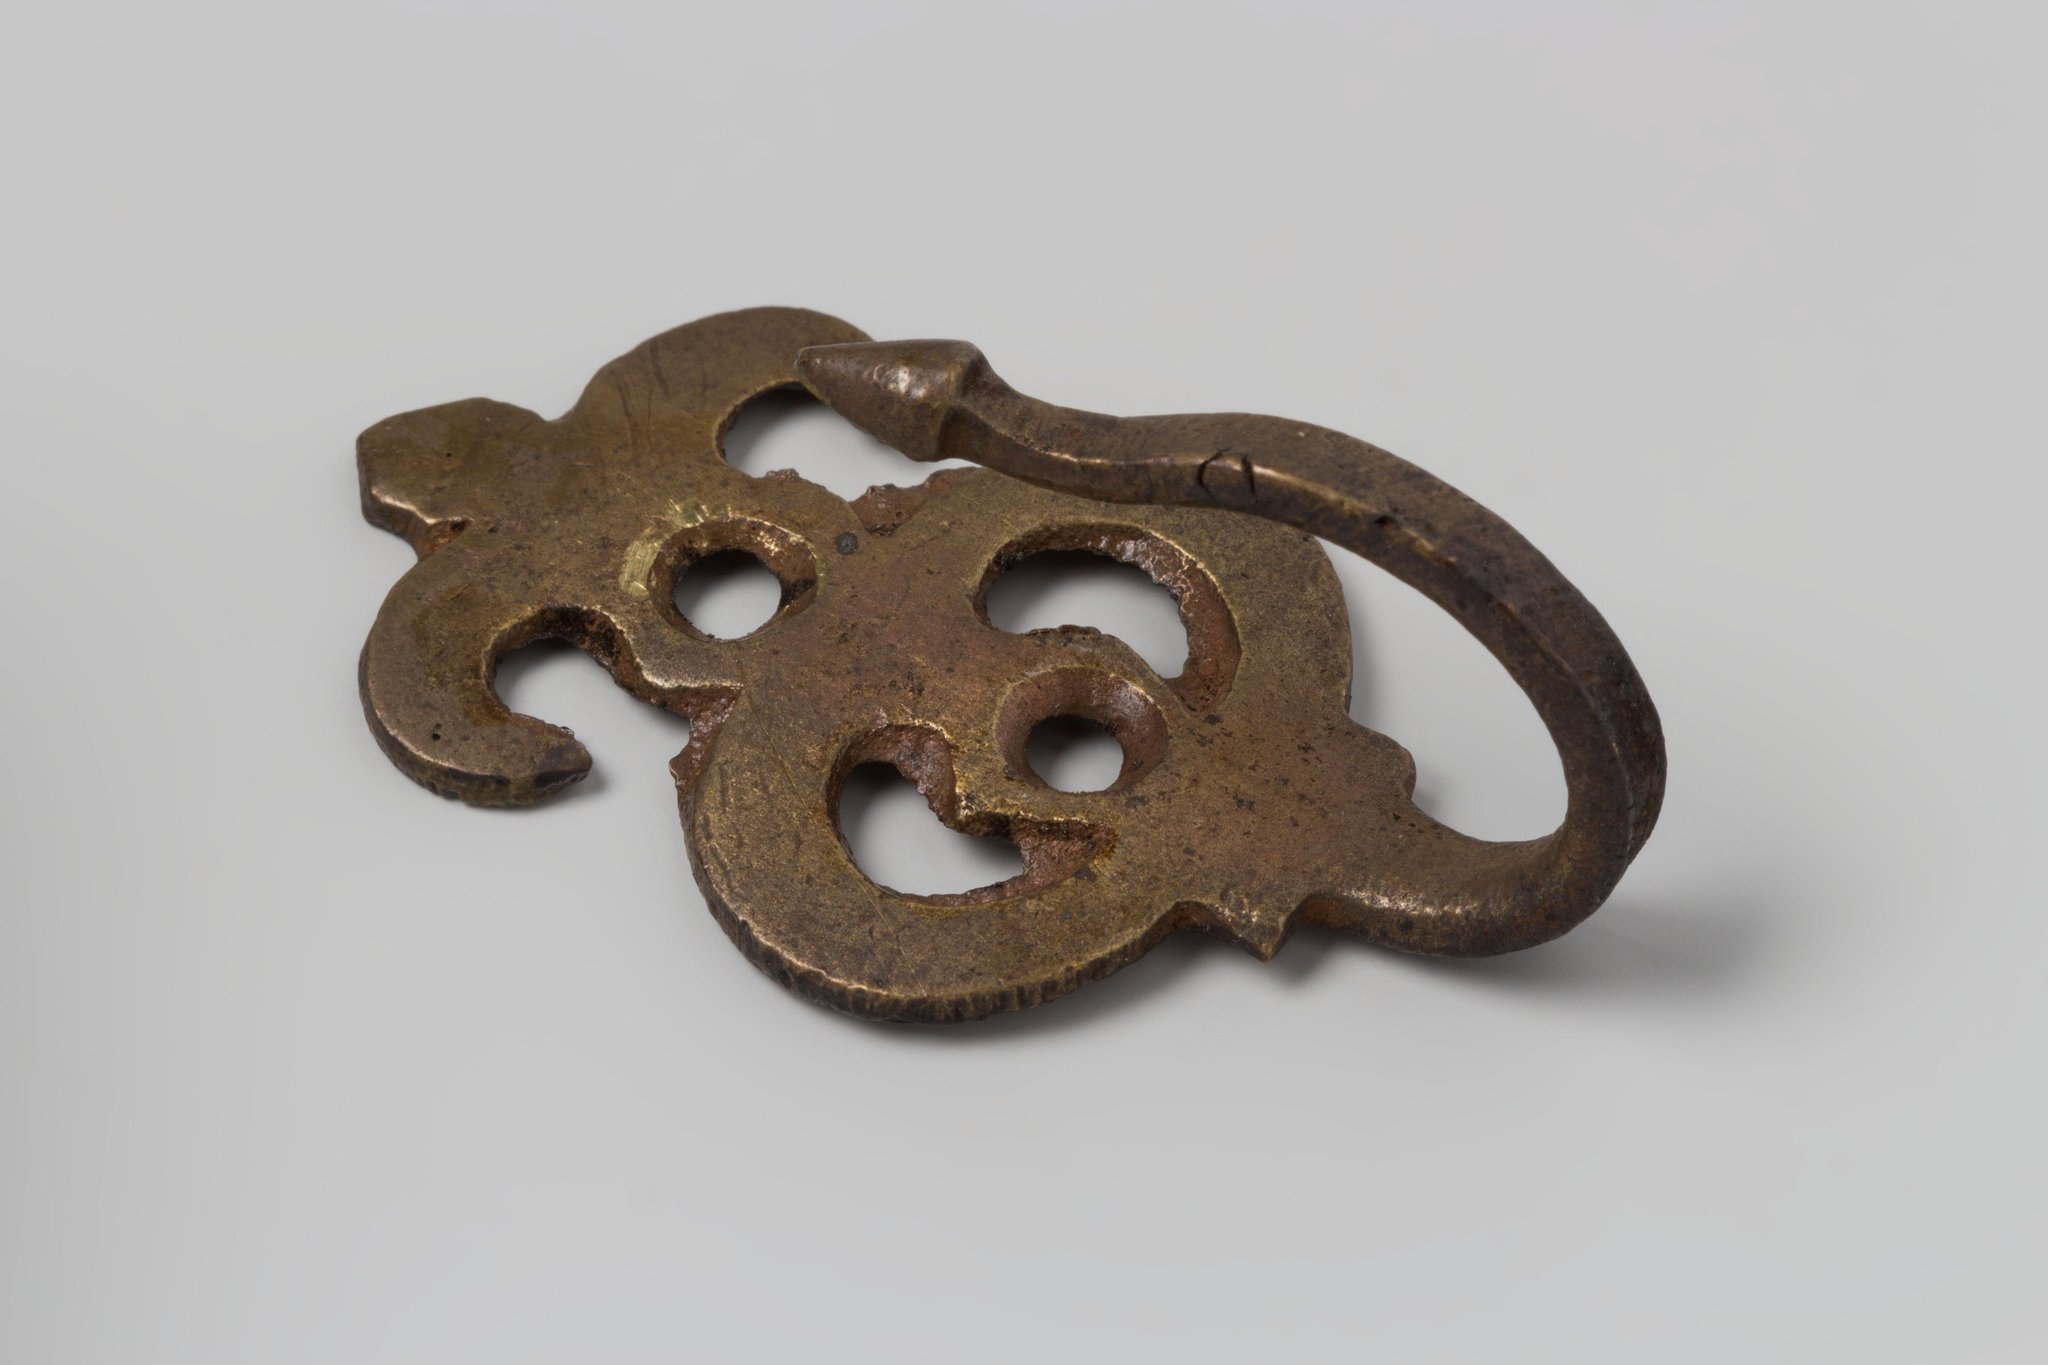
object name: hook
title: Muurhaak uit het wrak van de Oost-Indiëvaarder Hollandia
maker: Anonymous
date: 1700-1743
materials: copper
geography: netherlands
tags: verenigde oostindische compagnie, hollandia (schip), annet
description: Wall hook; consisting of flat wall plate, oval outline with fleur-de-lys shaped upper end, openwork decoration with 2 fitting holes, at lower end a looped rod, semicircular in section, tapering into cone-shaped point.